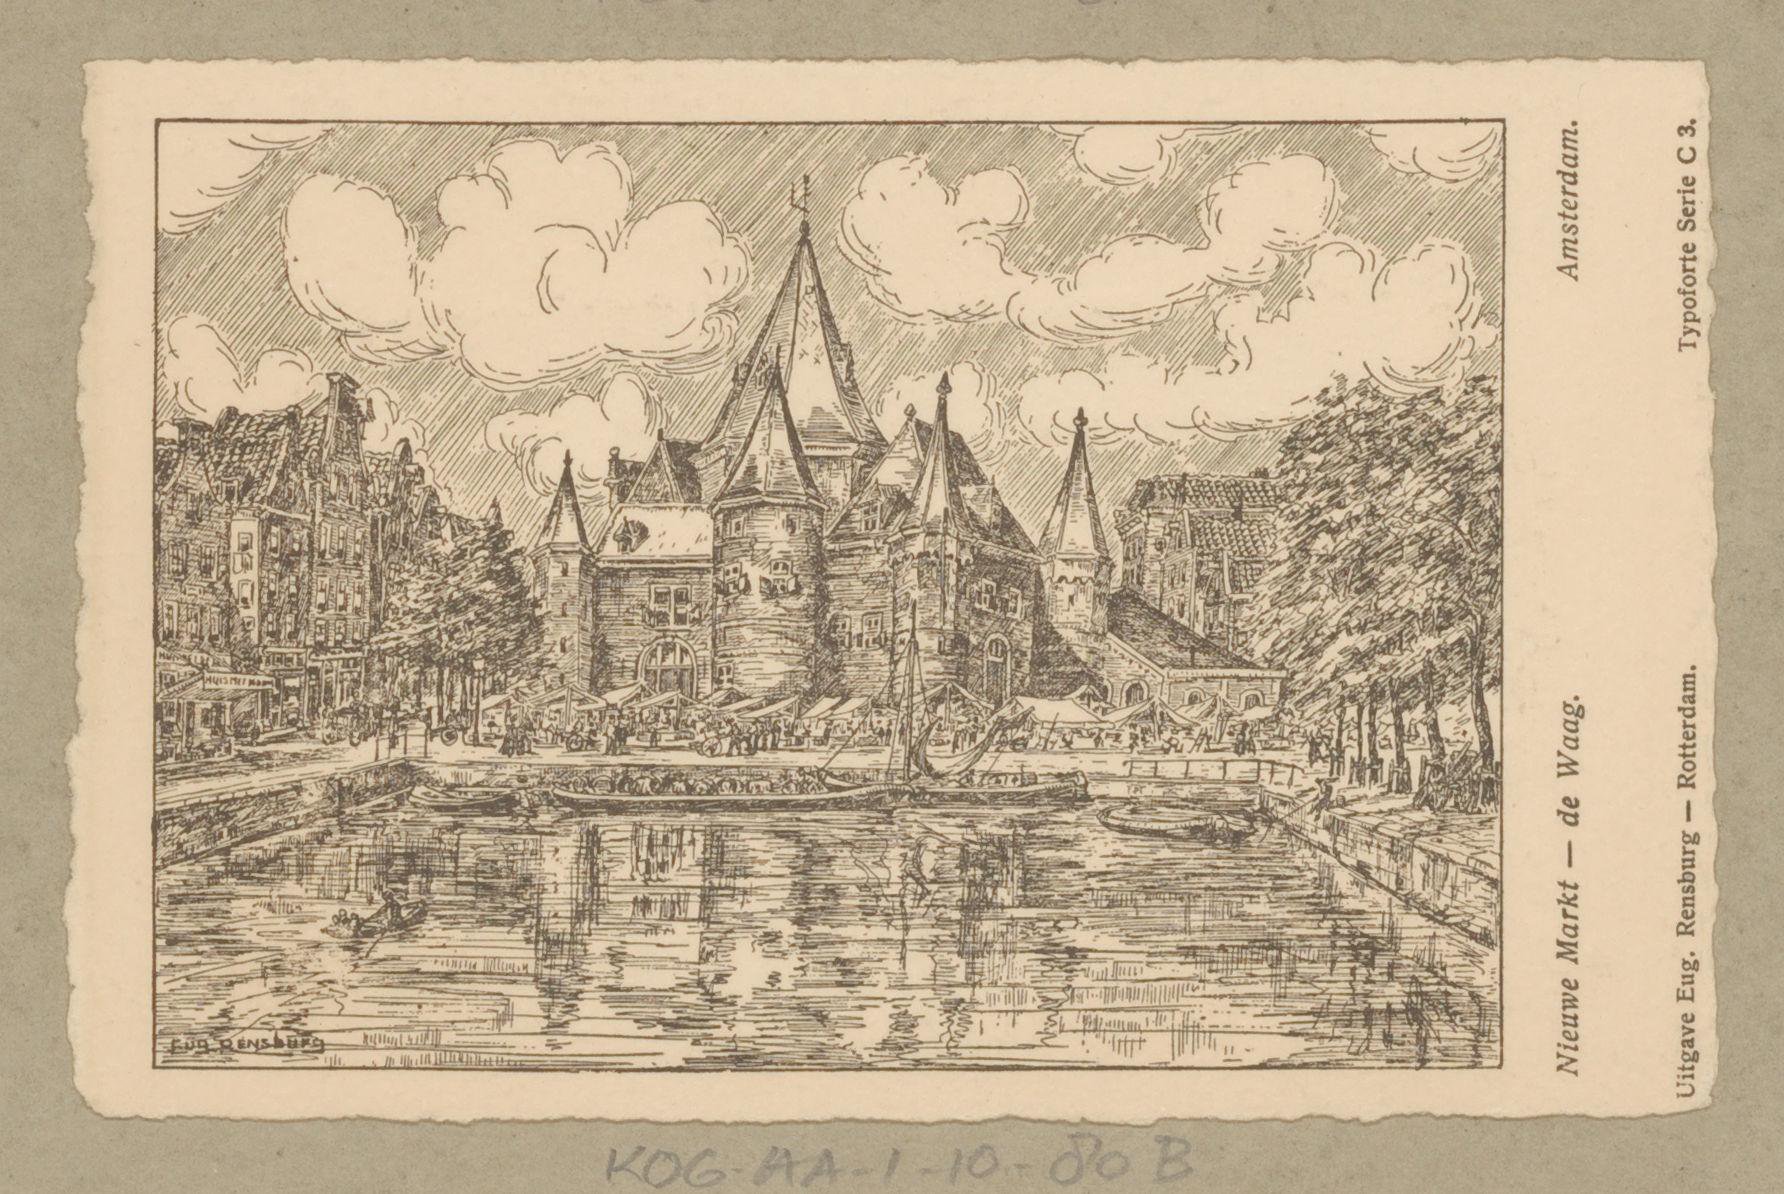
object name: ansichtkaart, prentbriefkaart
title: Gezicht op de Waag op de Nieuwmarkt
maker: eugène rensburg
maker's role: draughtsman, print maker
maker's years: 1872-1956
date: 1882-1956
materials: cardboard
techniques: letterpress printing, line block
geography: rotterdam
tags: square, place, circus, etc., city-view in general; 'veduta', canal, weigh-house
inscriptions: collector's mark: ‘10,80’ Lugt 1641b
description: Onderwerpsrubriek binnen de Atlas Amsterdam: Nieuwmarkt, Noordermarkt.